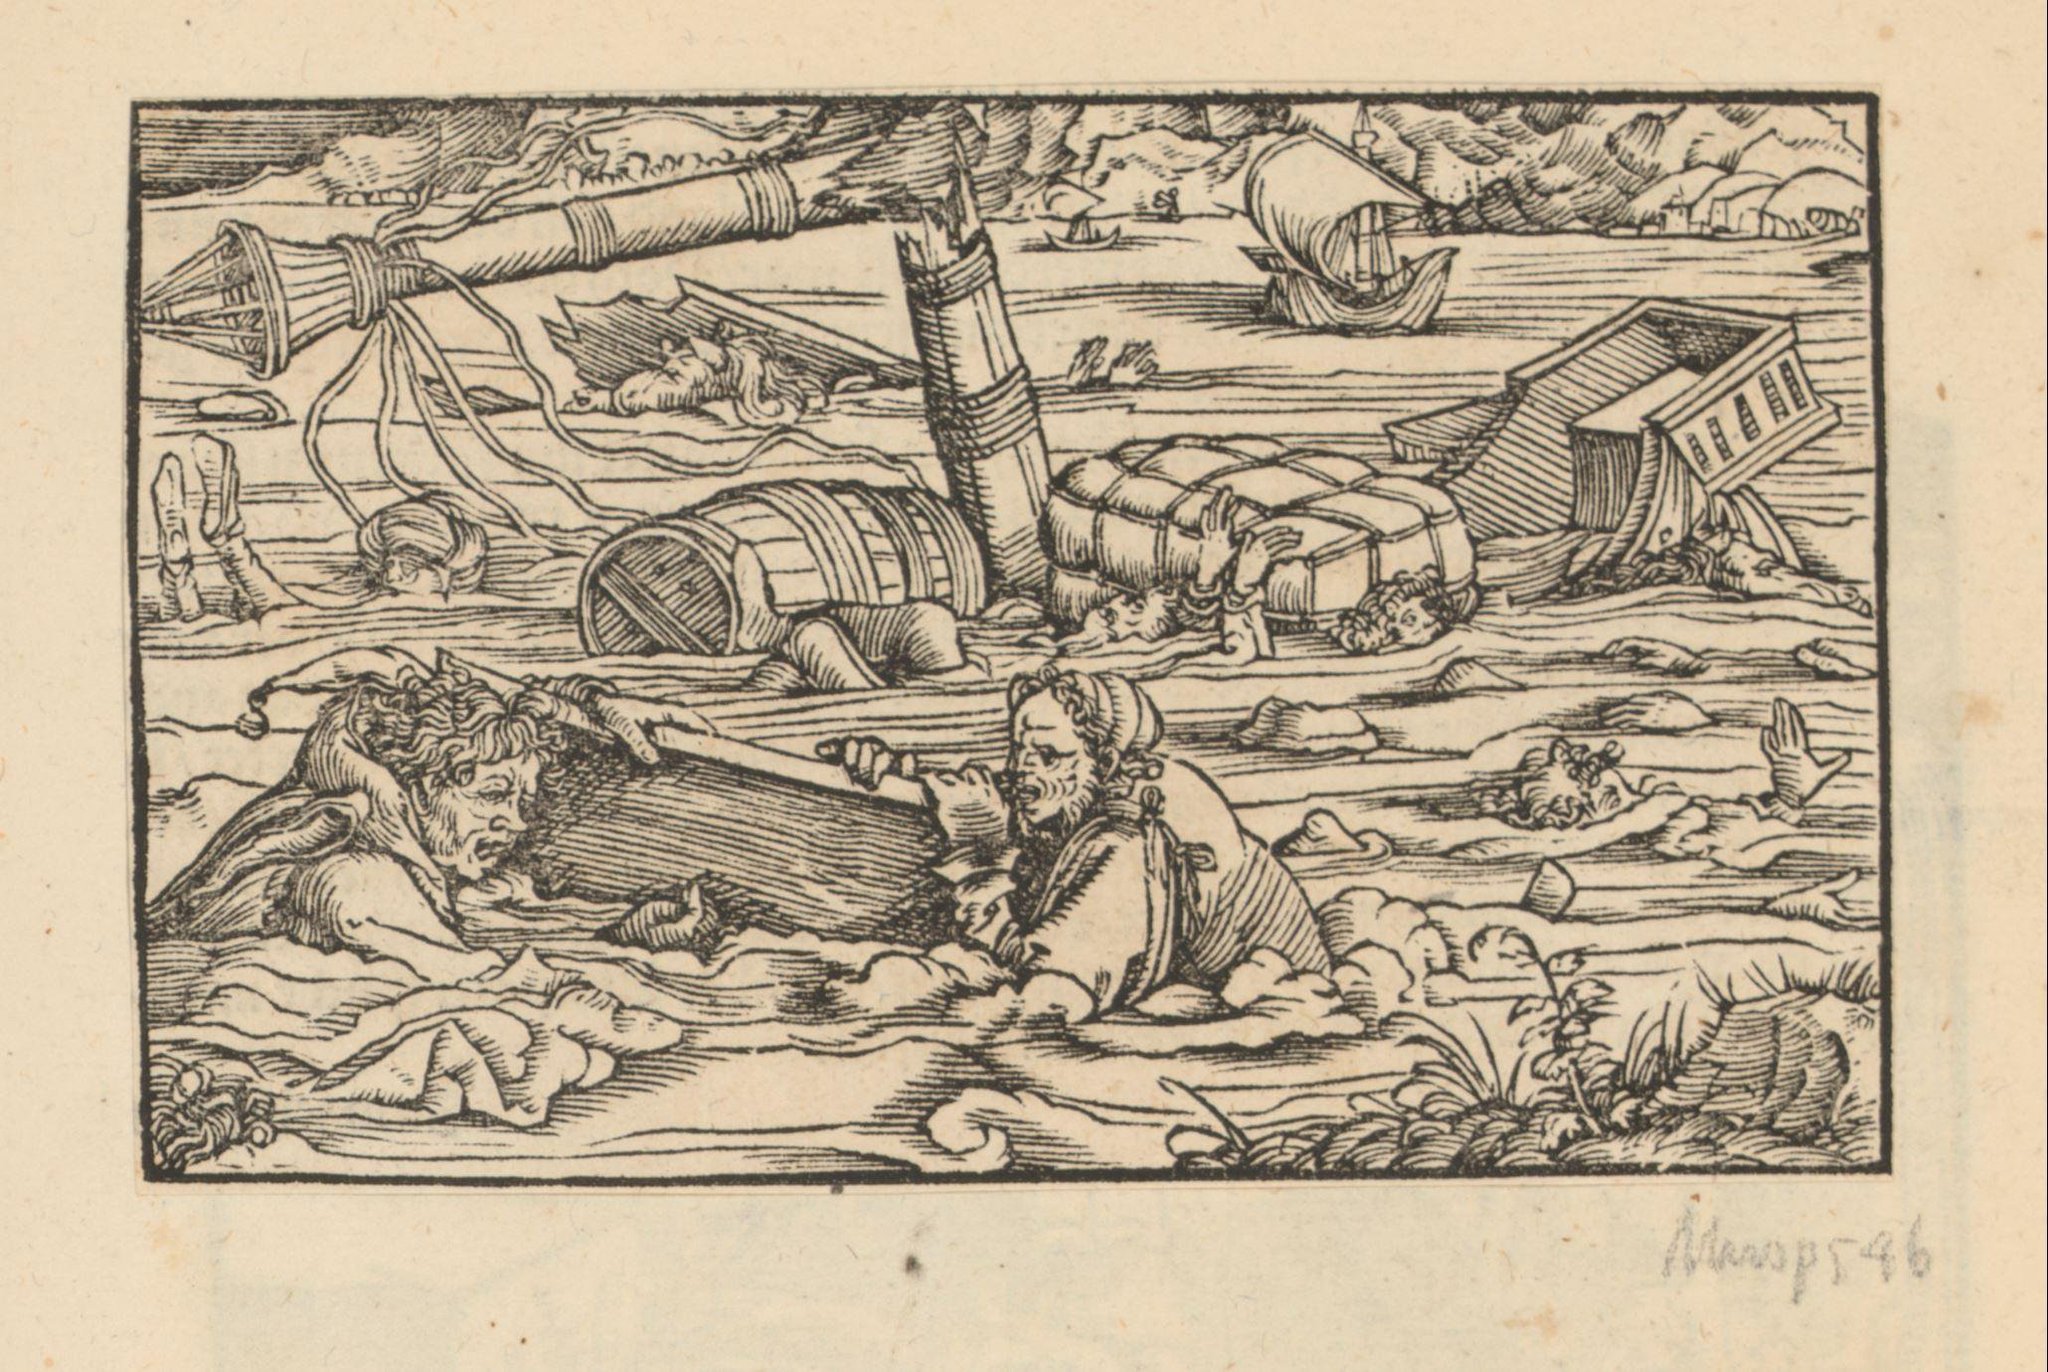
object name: album leaf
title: Drenkelingen van een schipbreuk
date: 1514-1531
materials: paper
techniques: letterpress printing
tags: shipwreck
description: Deze prent is gebruikt in: Cicero, Marcus Tulius. Officia M.T.C. Ein Buch so Marcus Tullius Cicero der Römer zu seynem (...). [Vertaald uit het Latijn door] Johann von Schwarzenberg. Augsburg: Heinrich Steiner, 1531.